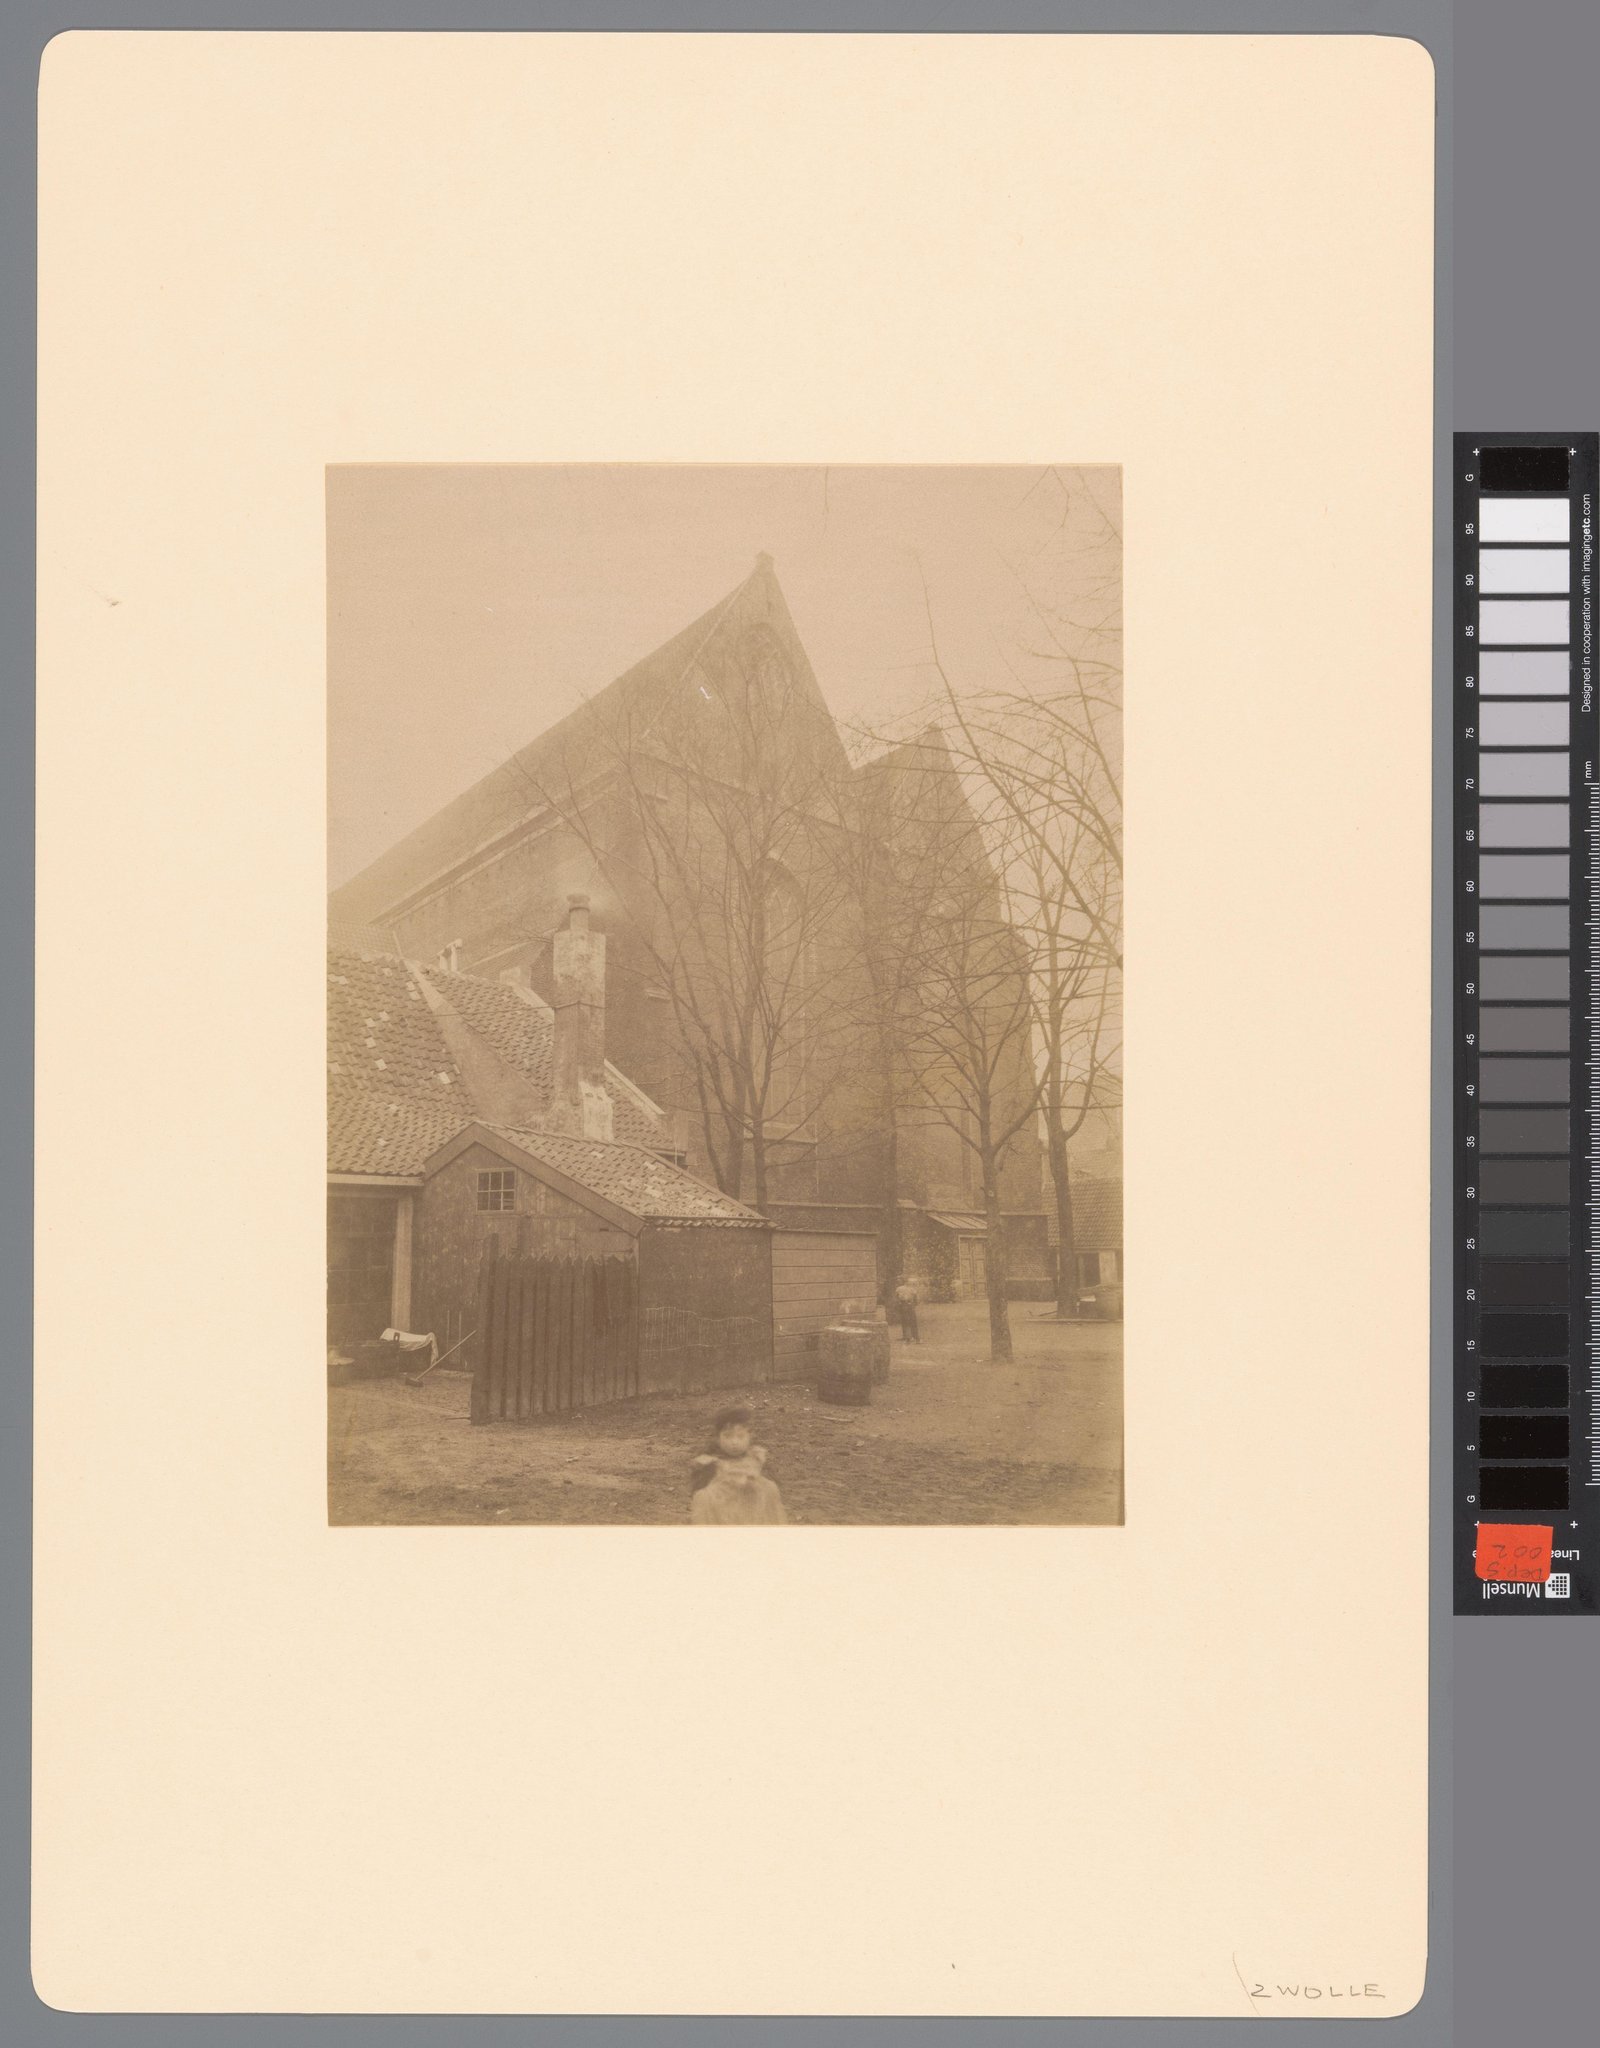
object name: photograph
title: Gezicht op de Broerenkerk te Zwolle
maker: anoniem (monumentenzorg)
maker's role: fotograaf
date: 1899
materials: cardboard, photographic support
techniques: albumen print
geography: zwolle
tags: church (exterior)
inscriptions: annotation: ‘Zwolle’, annotation: ‘Boerenkerk te Zwolle (O.IJ.)’